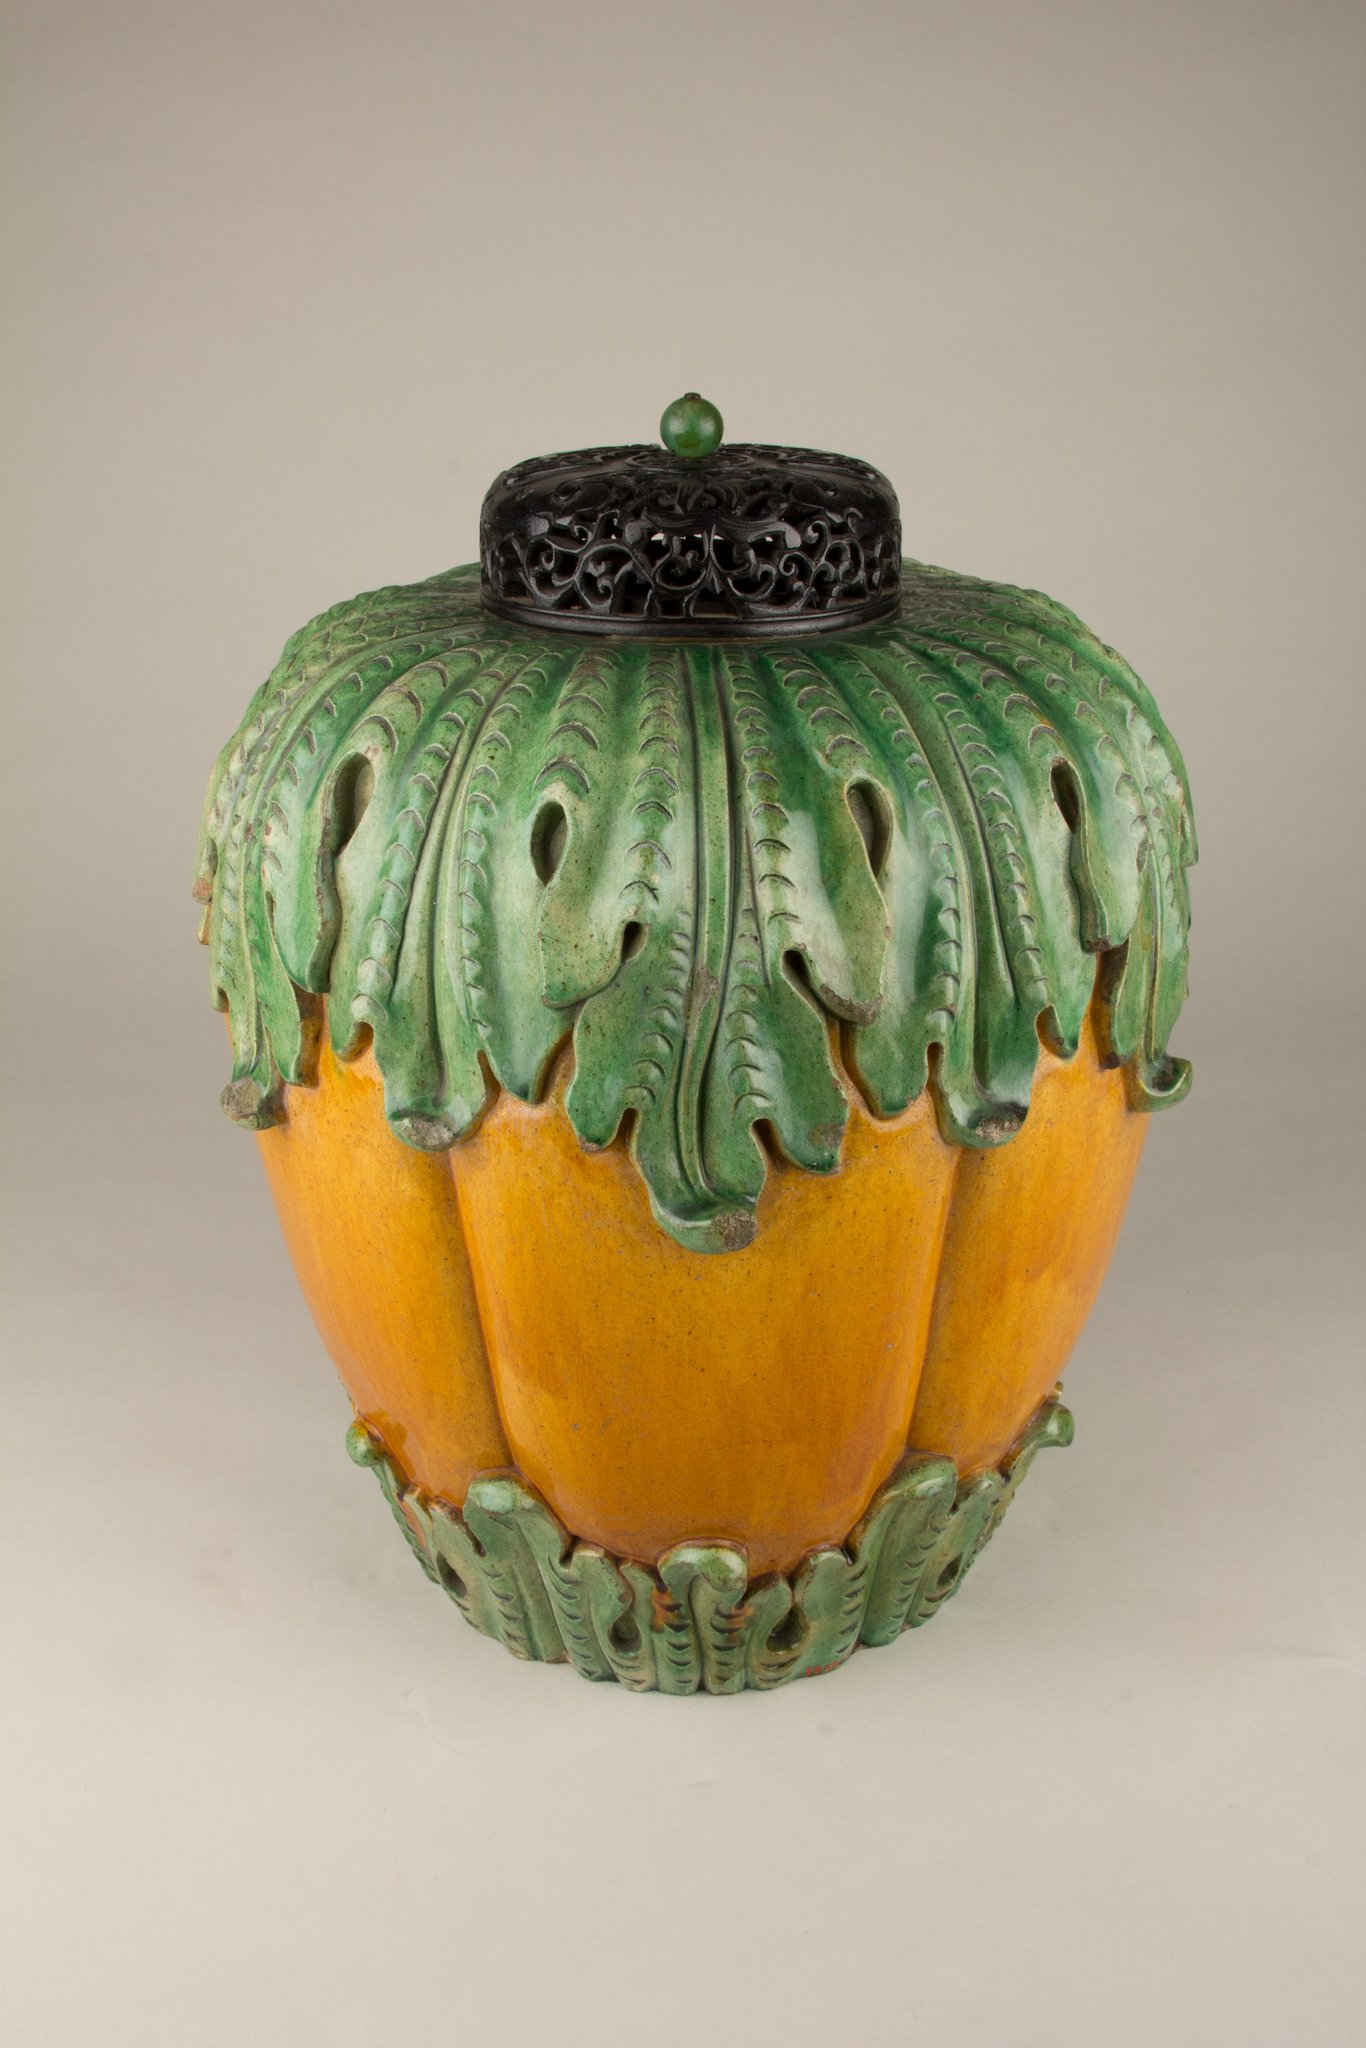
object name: jar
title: Jar (one of a pair)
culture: chinese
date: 1368-1644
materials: enamel, pottery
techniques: polychrome